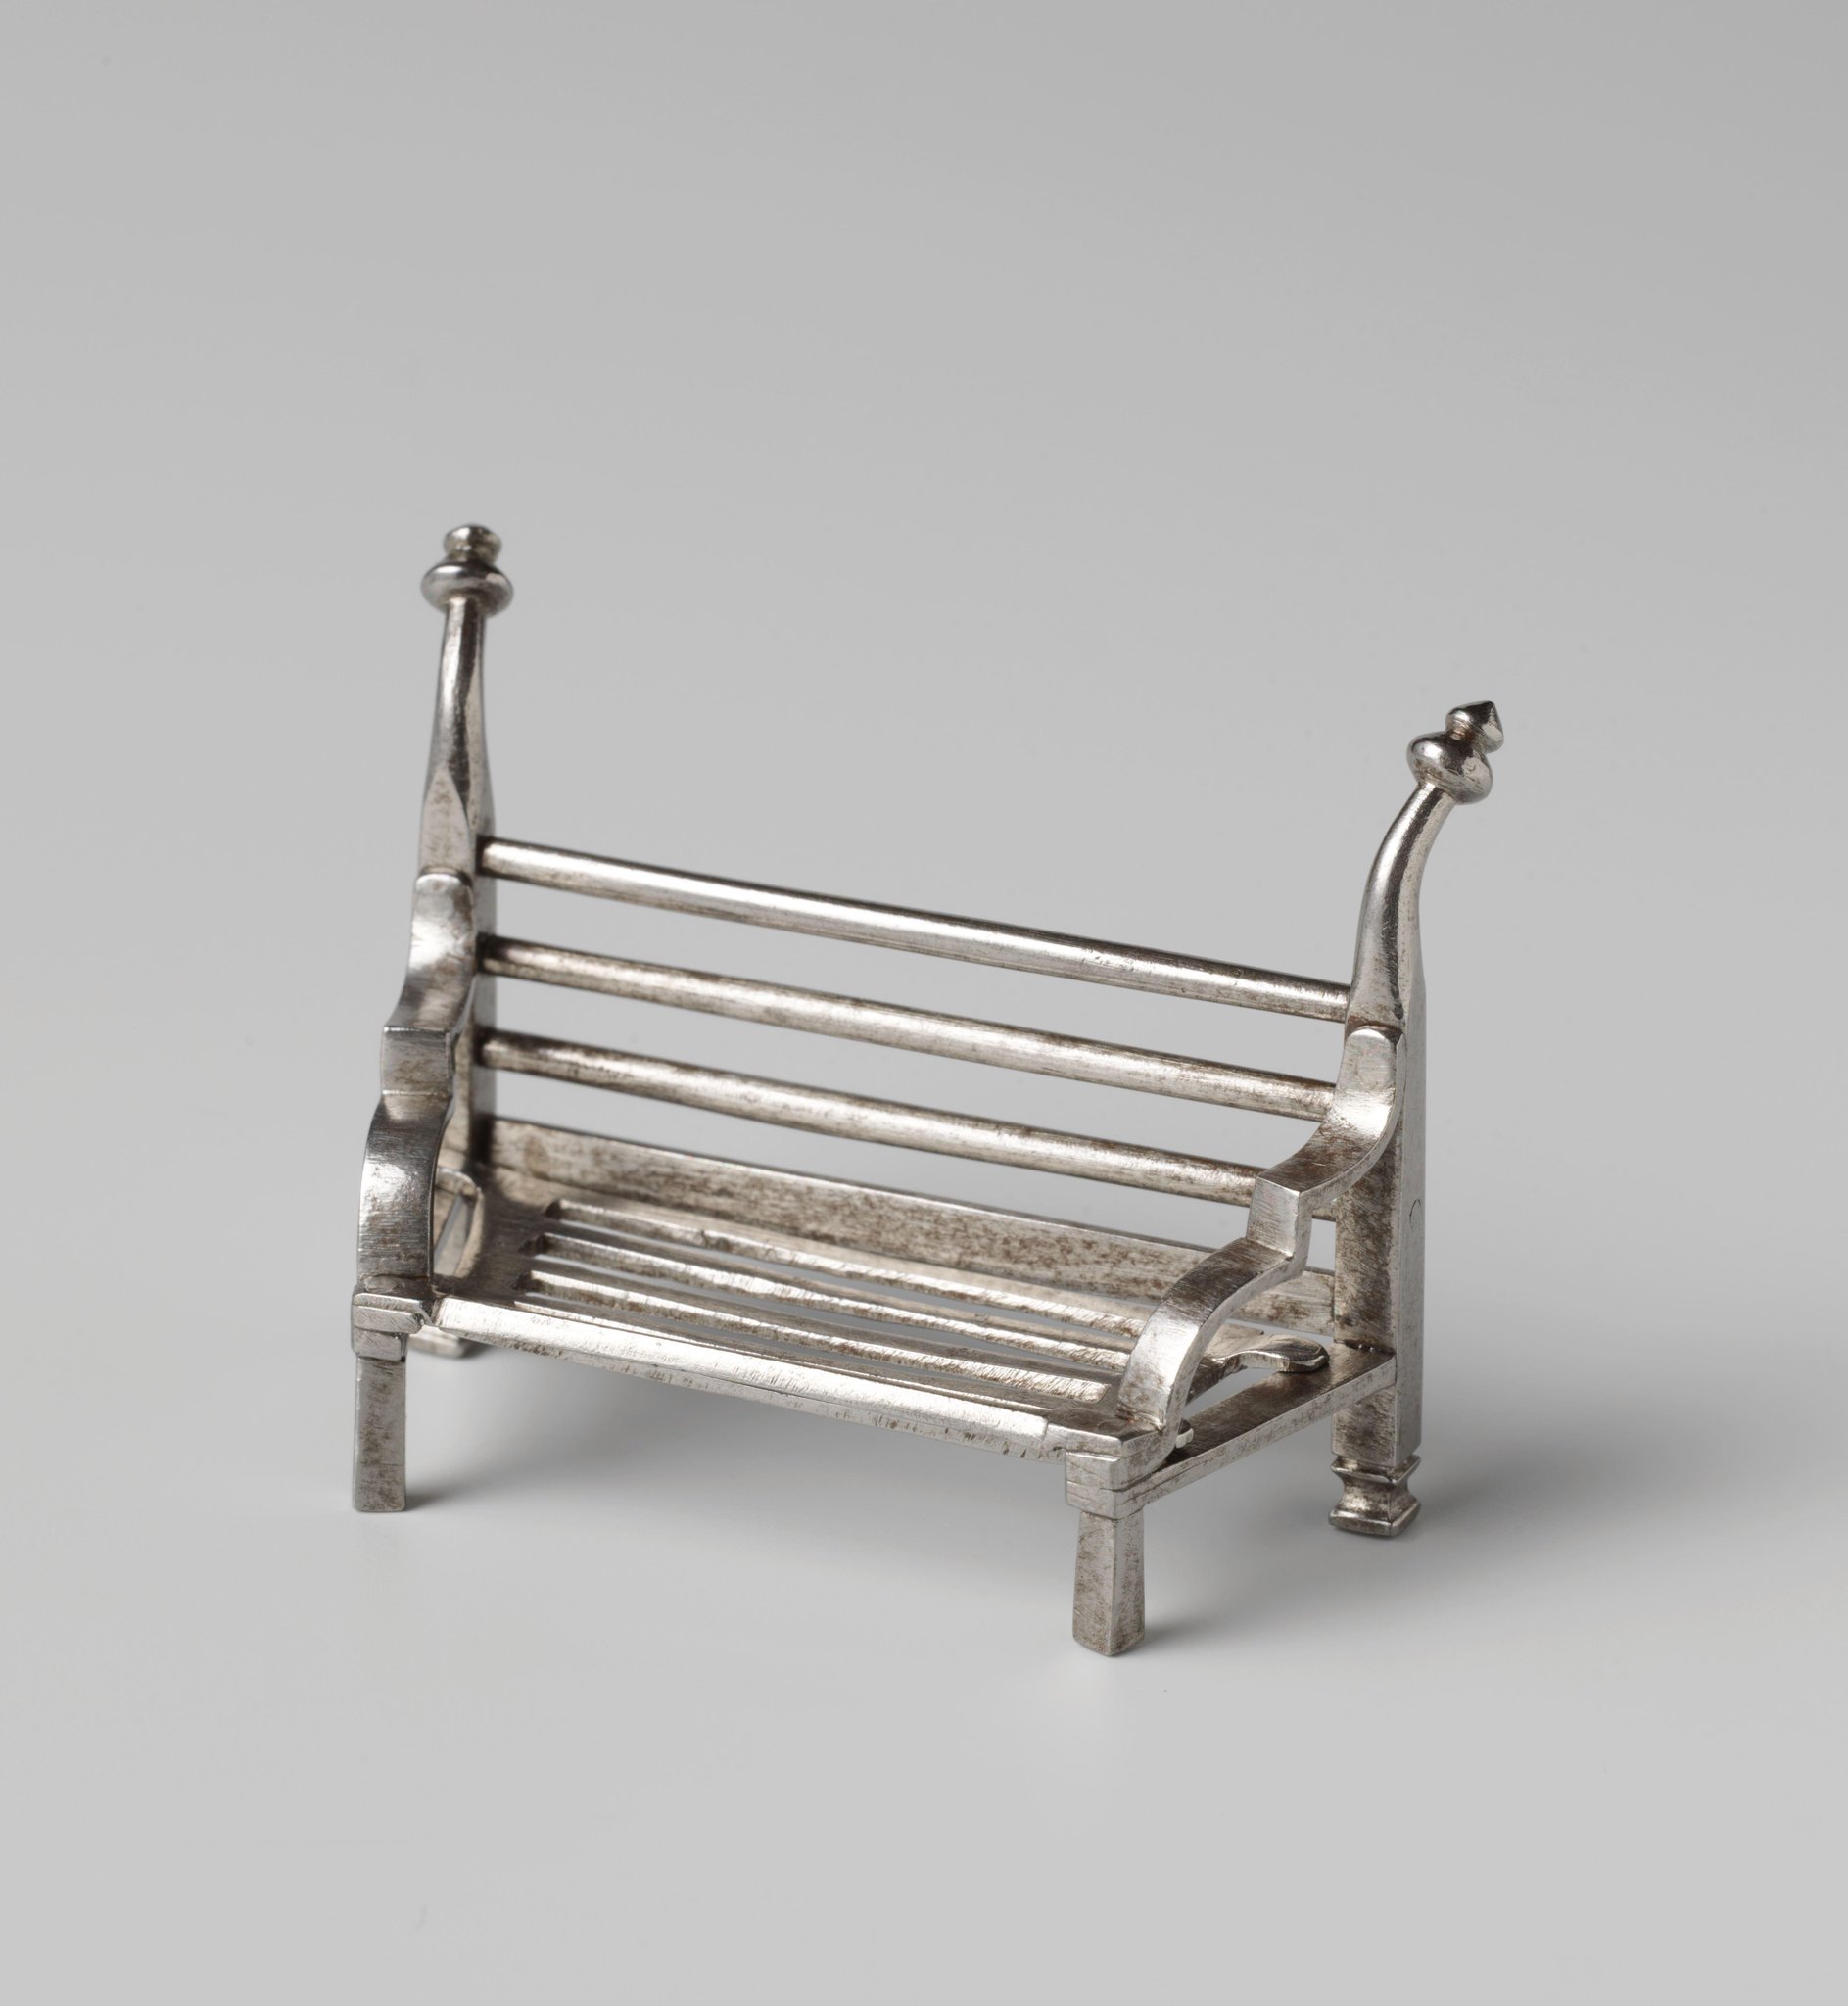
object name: vuurkorf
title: Vuurkorf, trapeziumvormig, de voorpoten met knopversiering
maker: Anonymous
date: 1750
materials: iron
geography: amsterdam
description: Vuurkorf van ijzer met een los rooster. De korf is trapeziumvormig. De voorpoten eindigen in knopversieringen. De voor- en achterpoten zijn verbonden door hol- en bolvormige sierverbindingen.